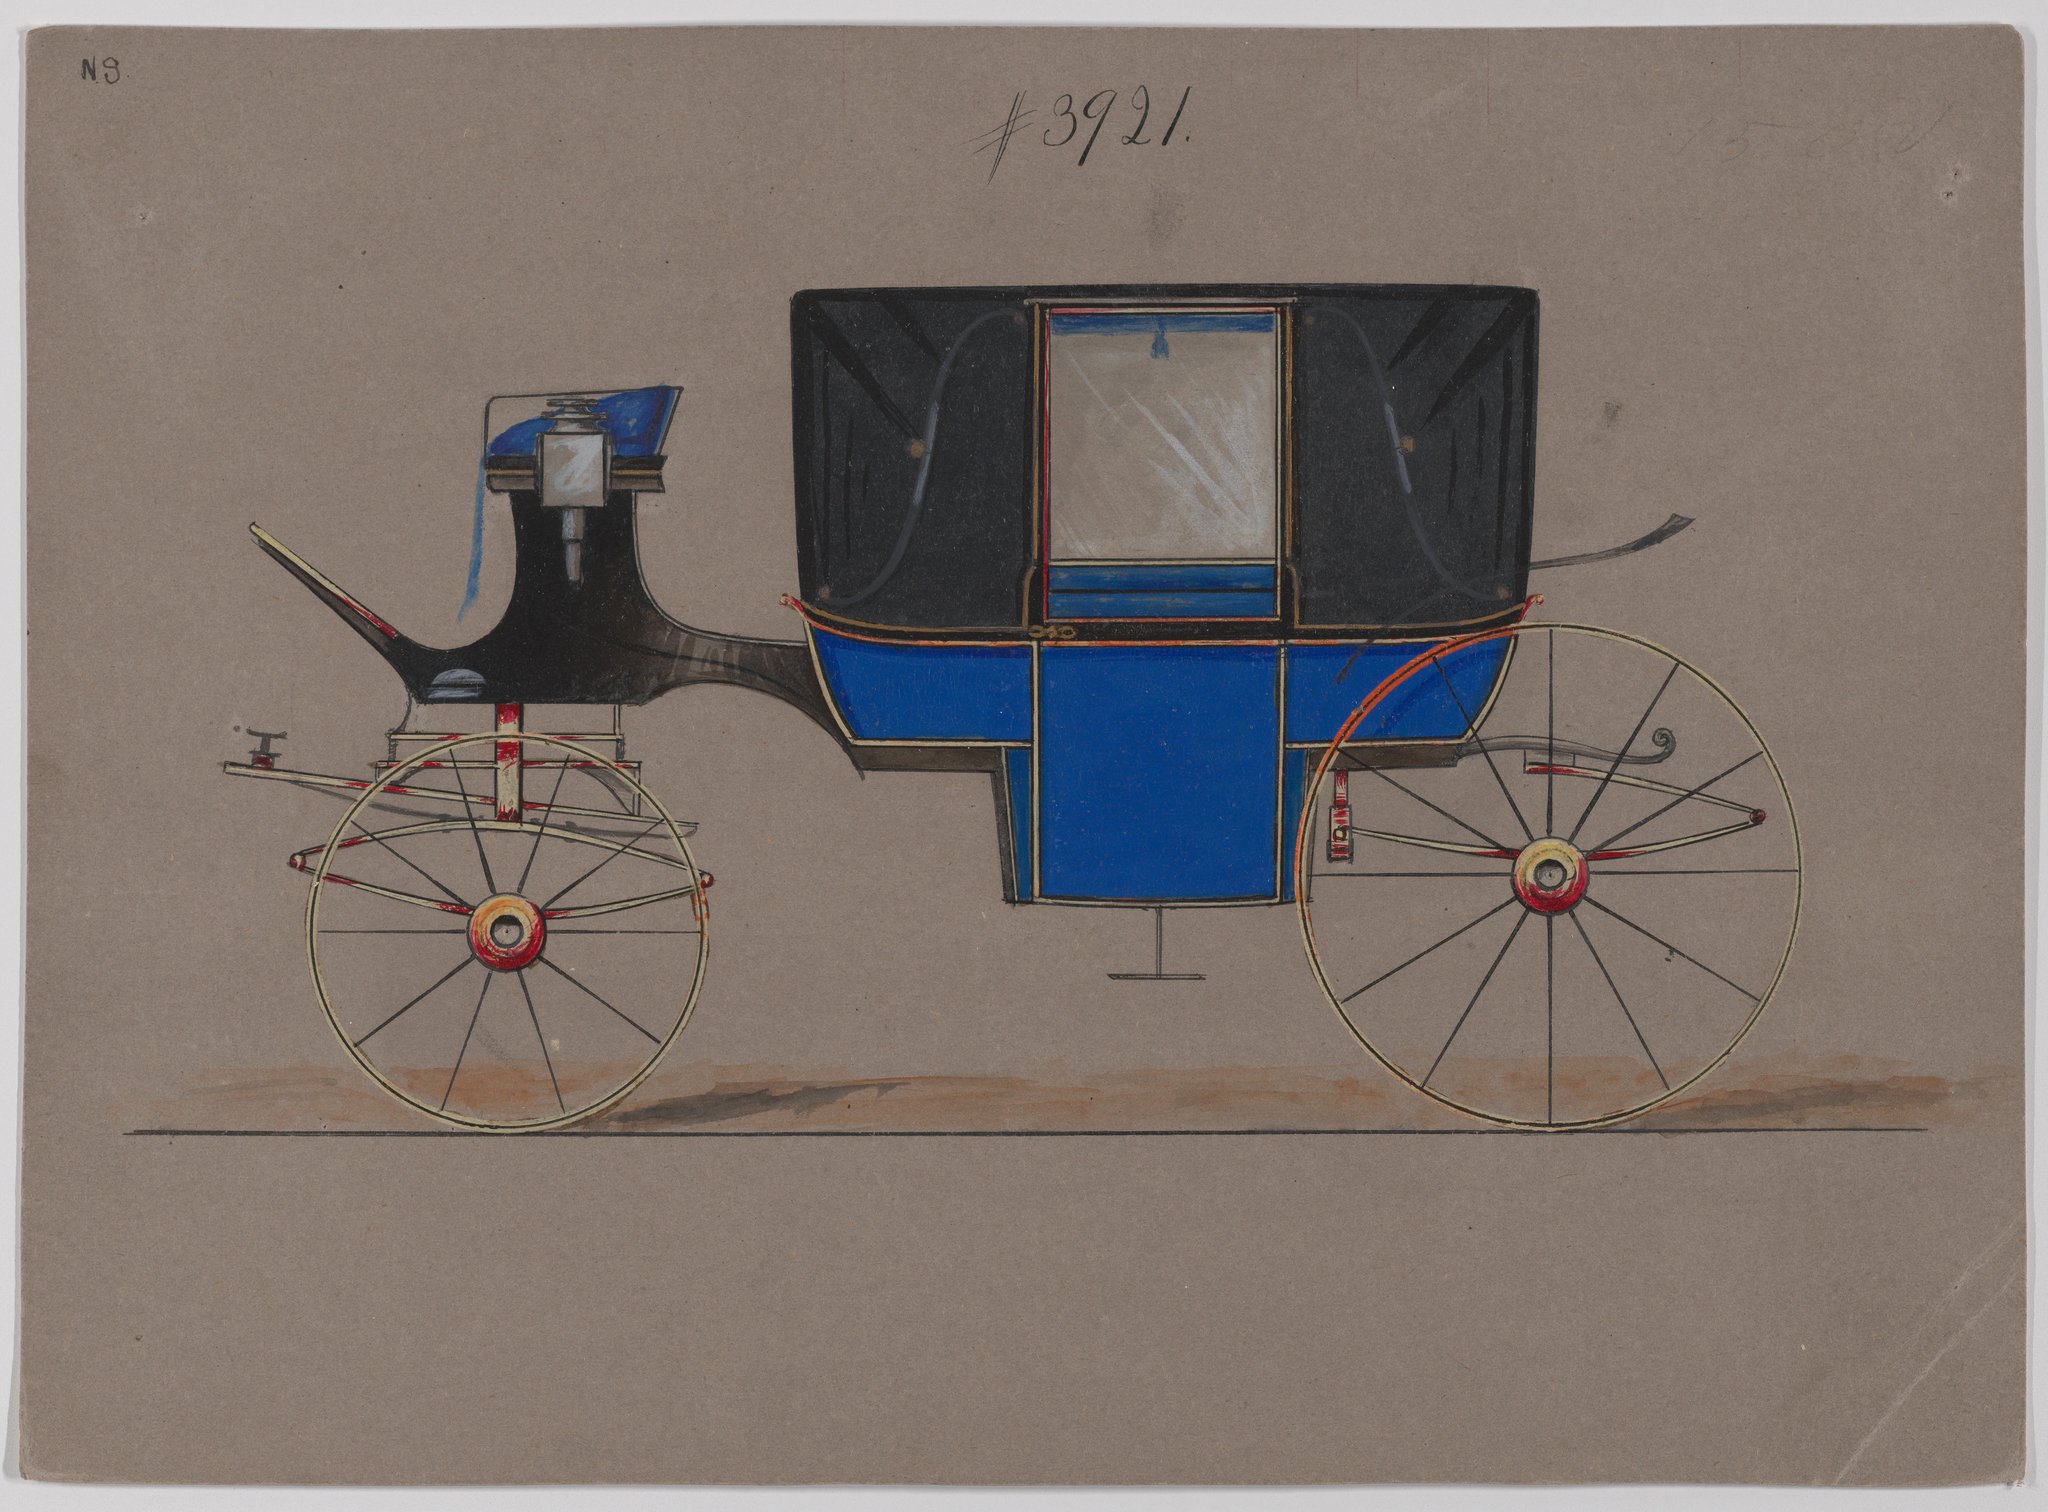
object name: drawing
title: Design for Landau, No. 3921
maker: brewster & co.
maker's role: manufacturer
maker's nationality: american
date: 1884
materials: gouache, gum arabic, ink, watercolor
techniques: pen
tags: carriages